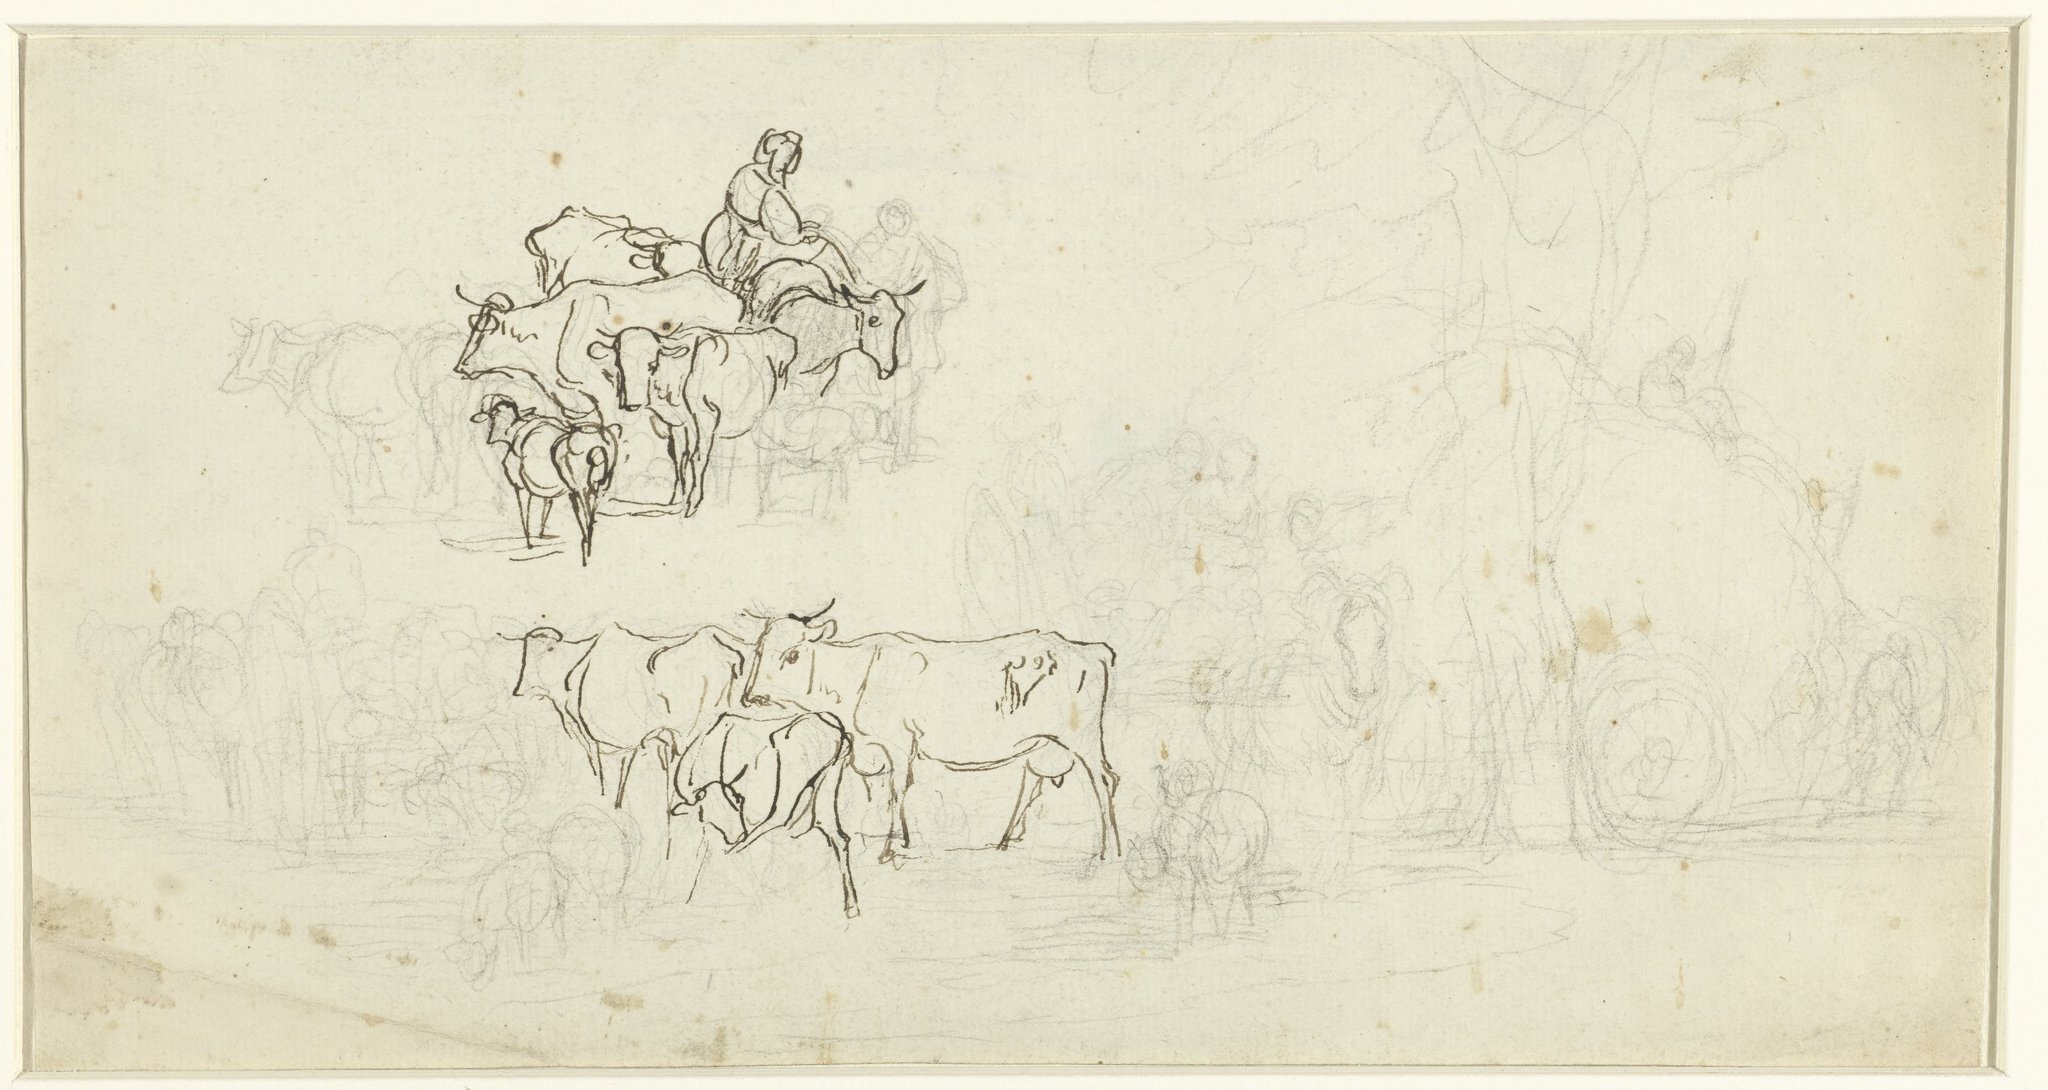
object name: drawing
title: Studies van groepen runderen, een boerenkar en een hooiwagen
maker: jean louis demarne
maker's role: draughtsman, painter, print maker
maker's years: 1752-1829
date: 1754-1829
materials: chalk, ink, paper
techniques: pen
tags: hay-wagon